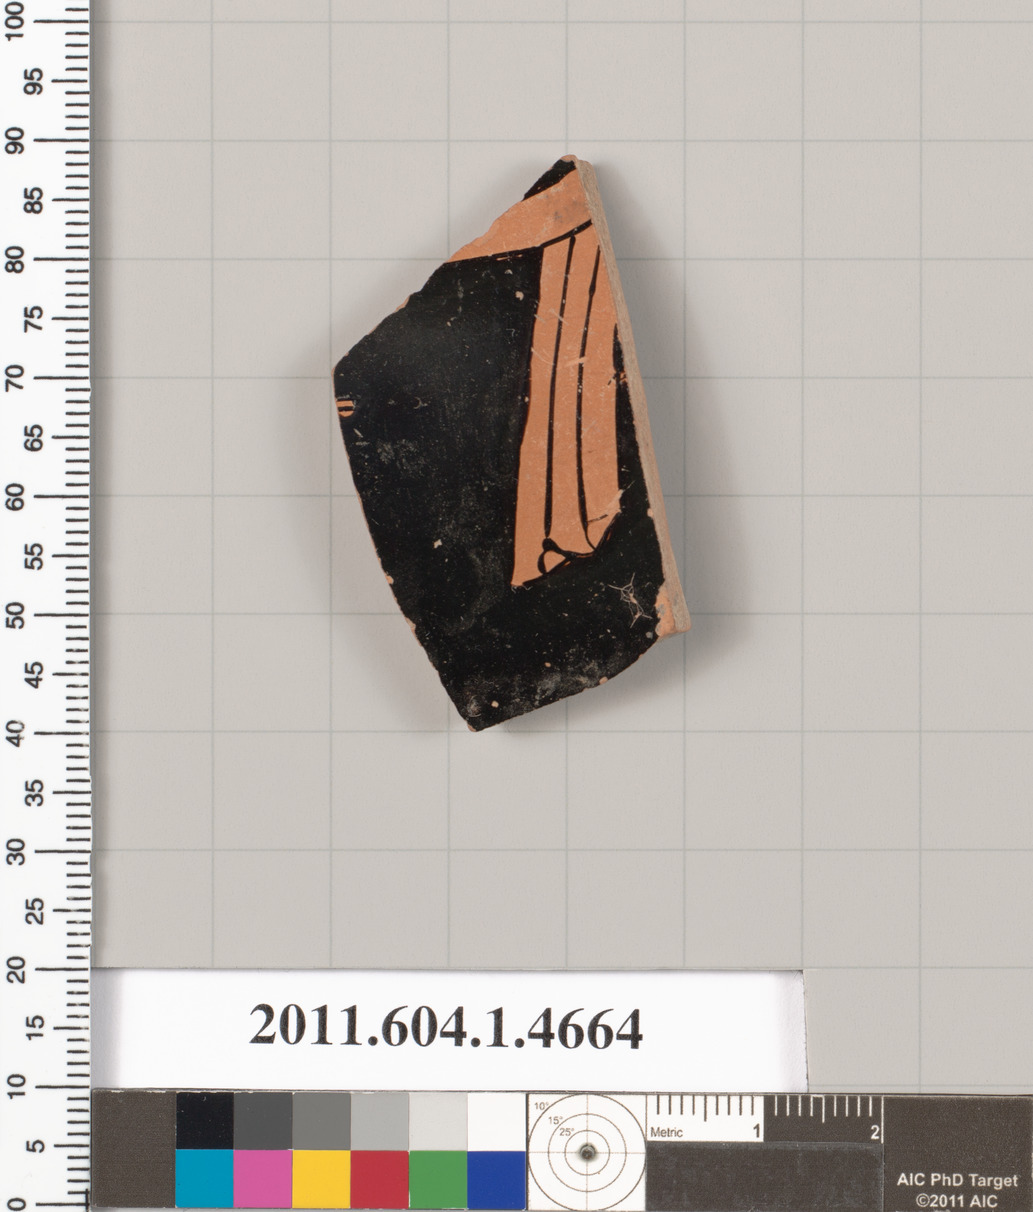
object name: kylix fragment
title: Terracotta fragment of a kylix (drinking cup)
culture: greek, attic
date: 500-480 BCE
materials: terracotta